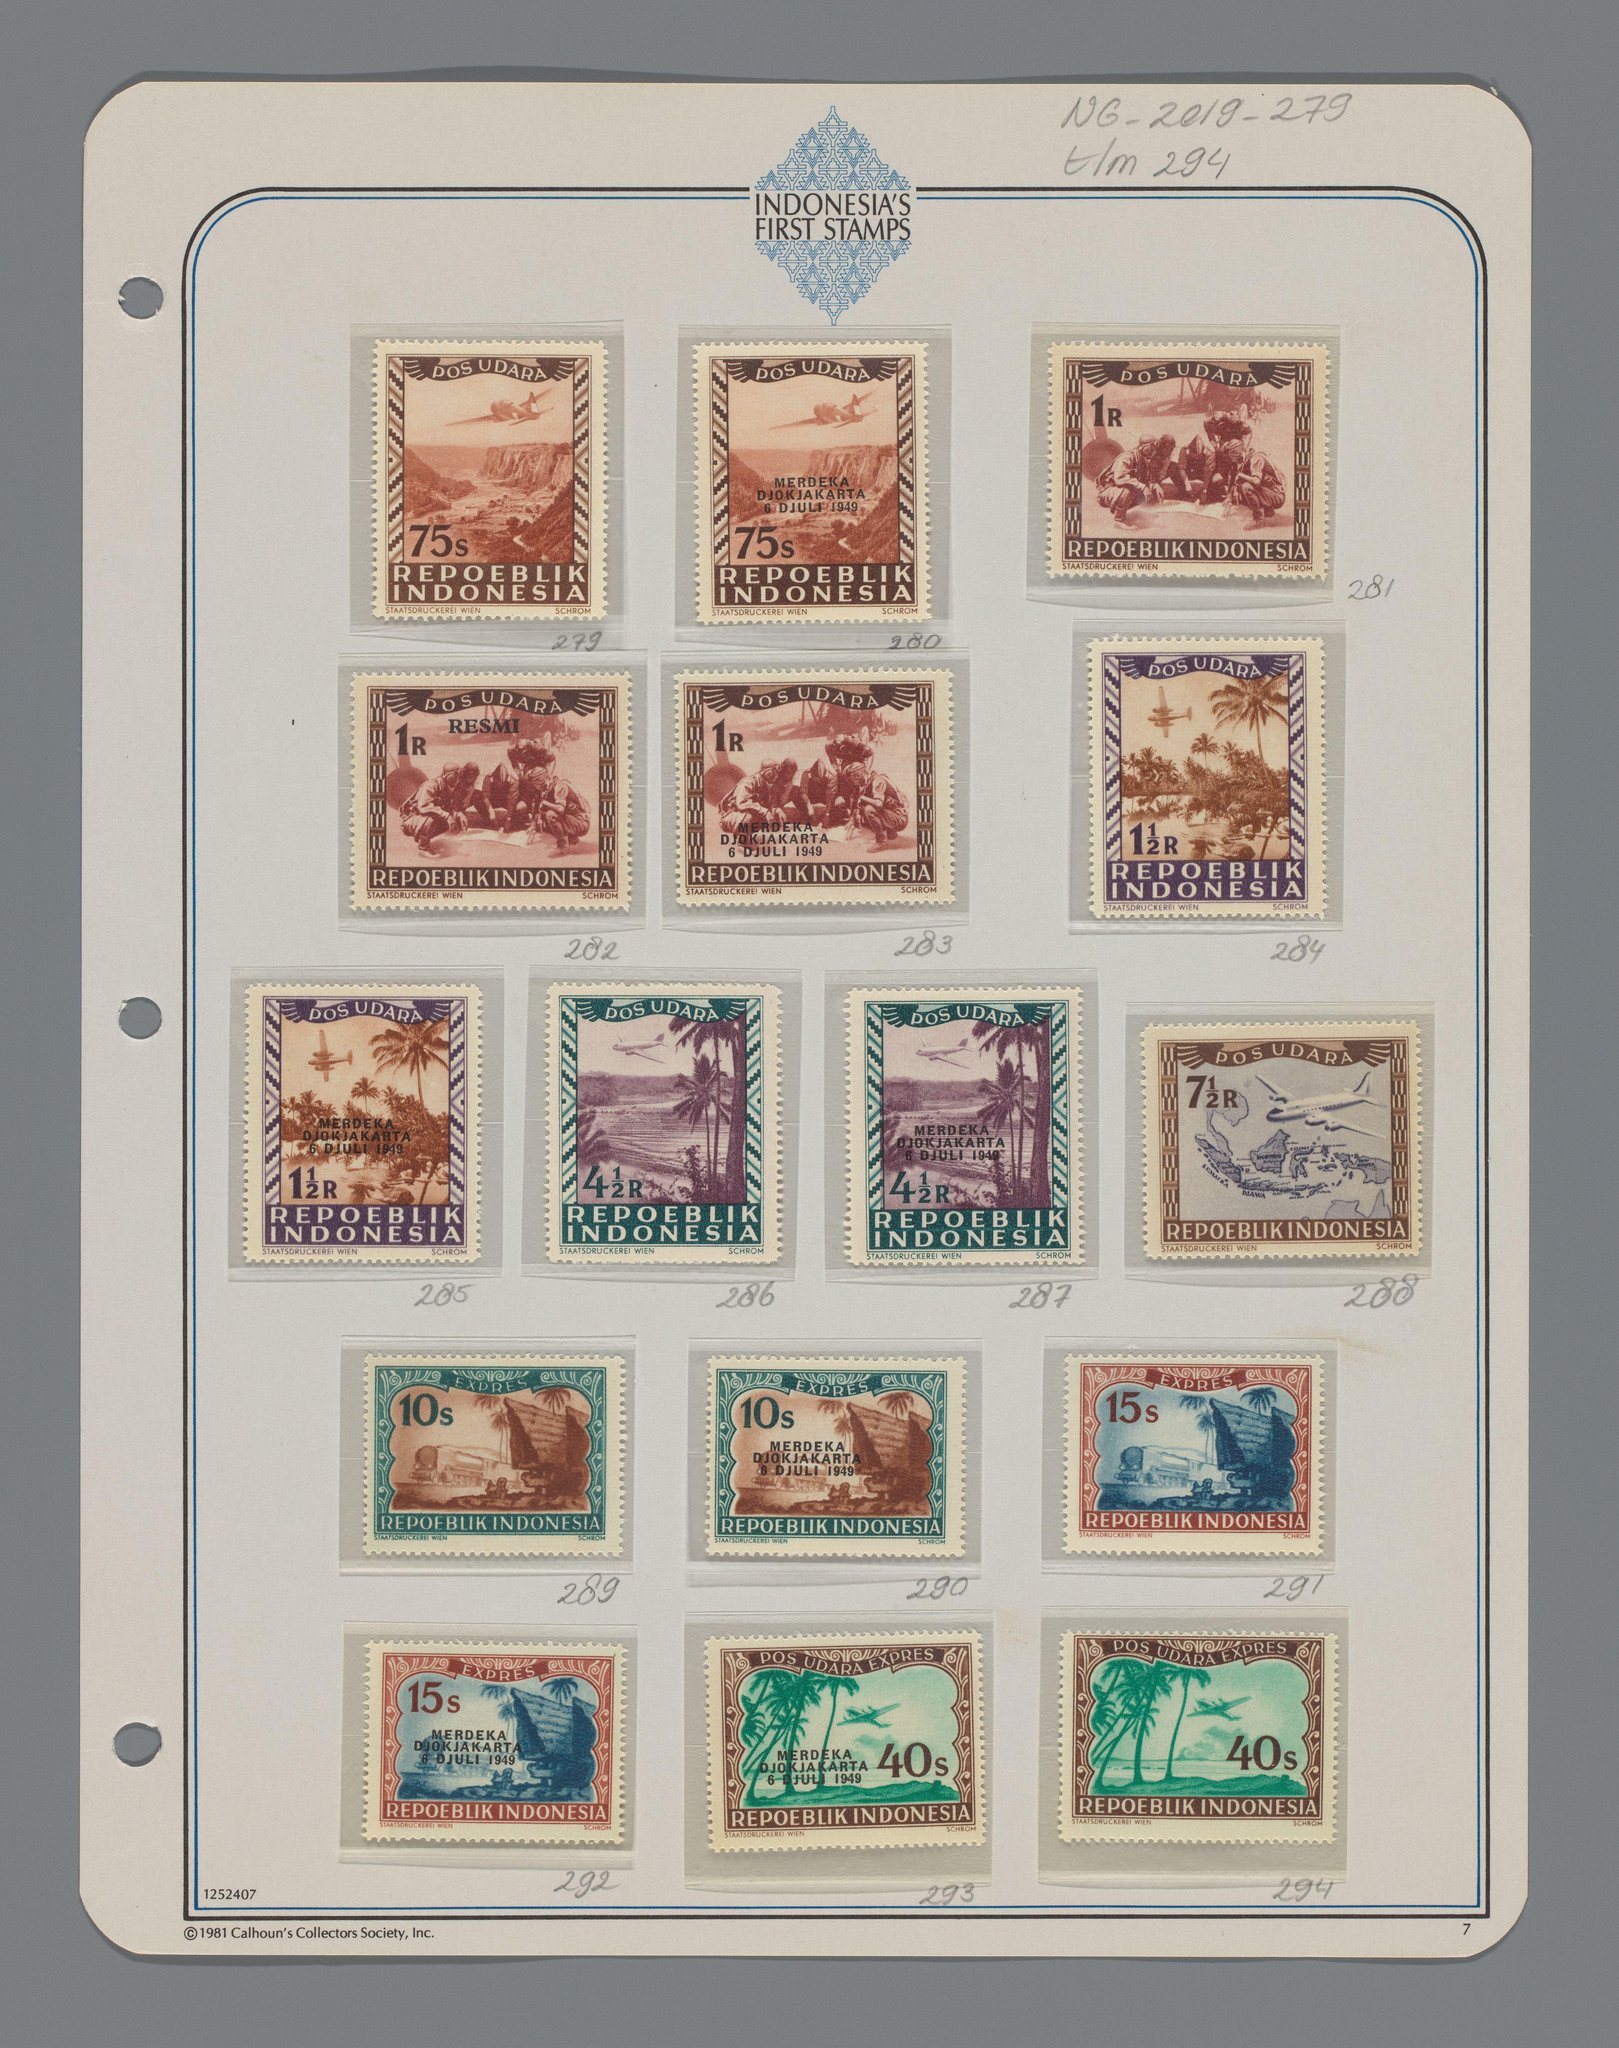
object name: postage stamp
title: Postzegel Republik Indonesia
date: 1949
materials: paper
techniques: photoaquatint, engraving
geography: vienna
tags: indonesia